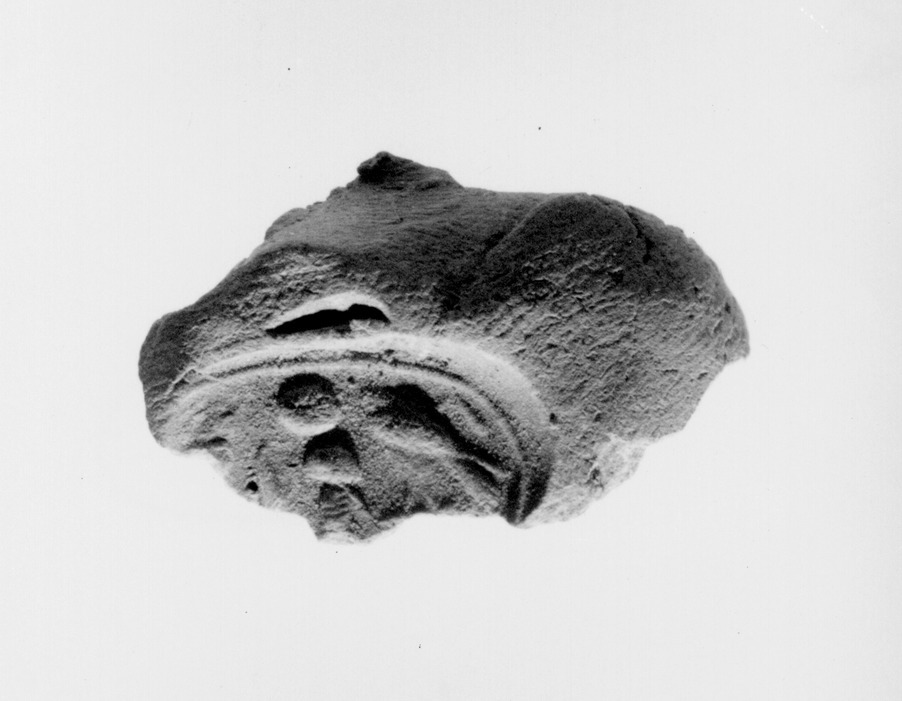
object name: sealing, nebmaatre, amenhotep iii, horus, falcon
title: Document Sealing with the Throne Name of Amenhotep III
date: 1390-1352 BCE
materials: mud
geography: egypt